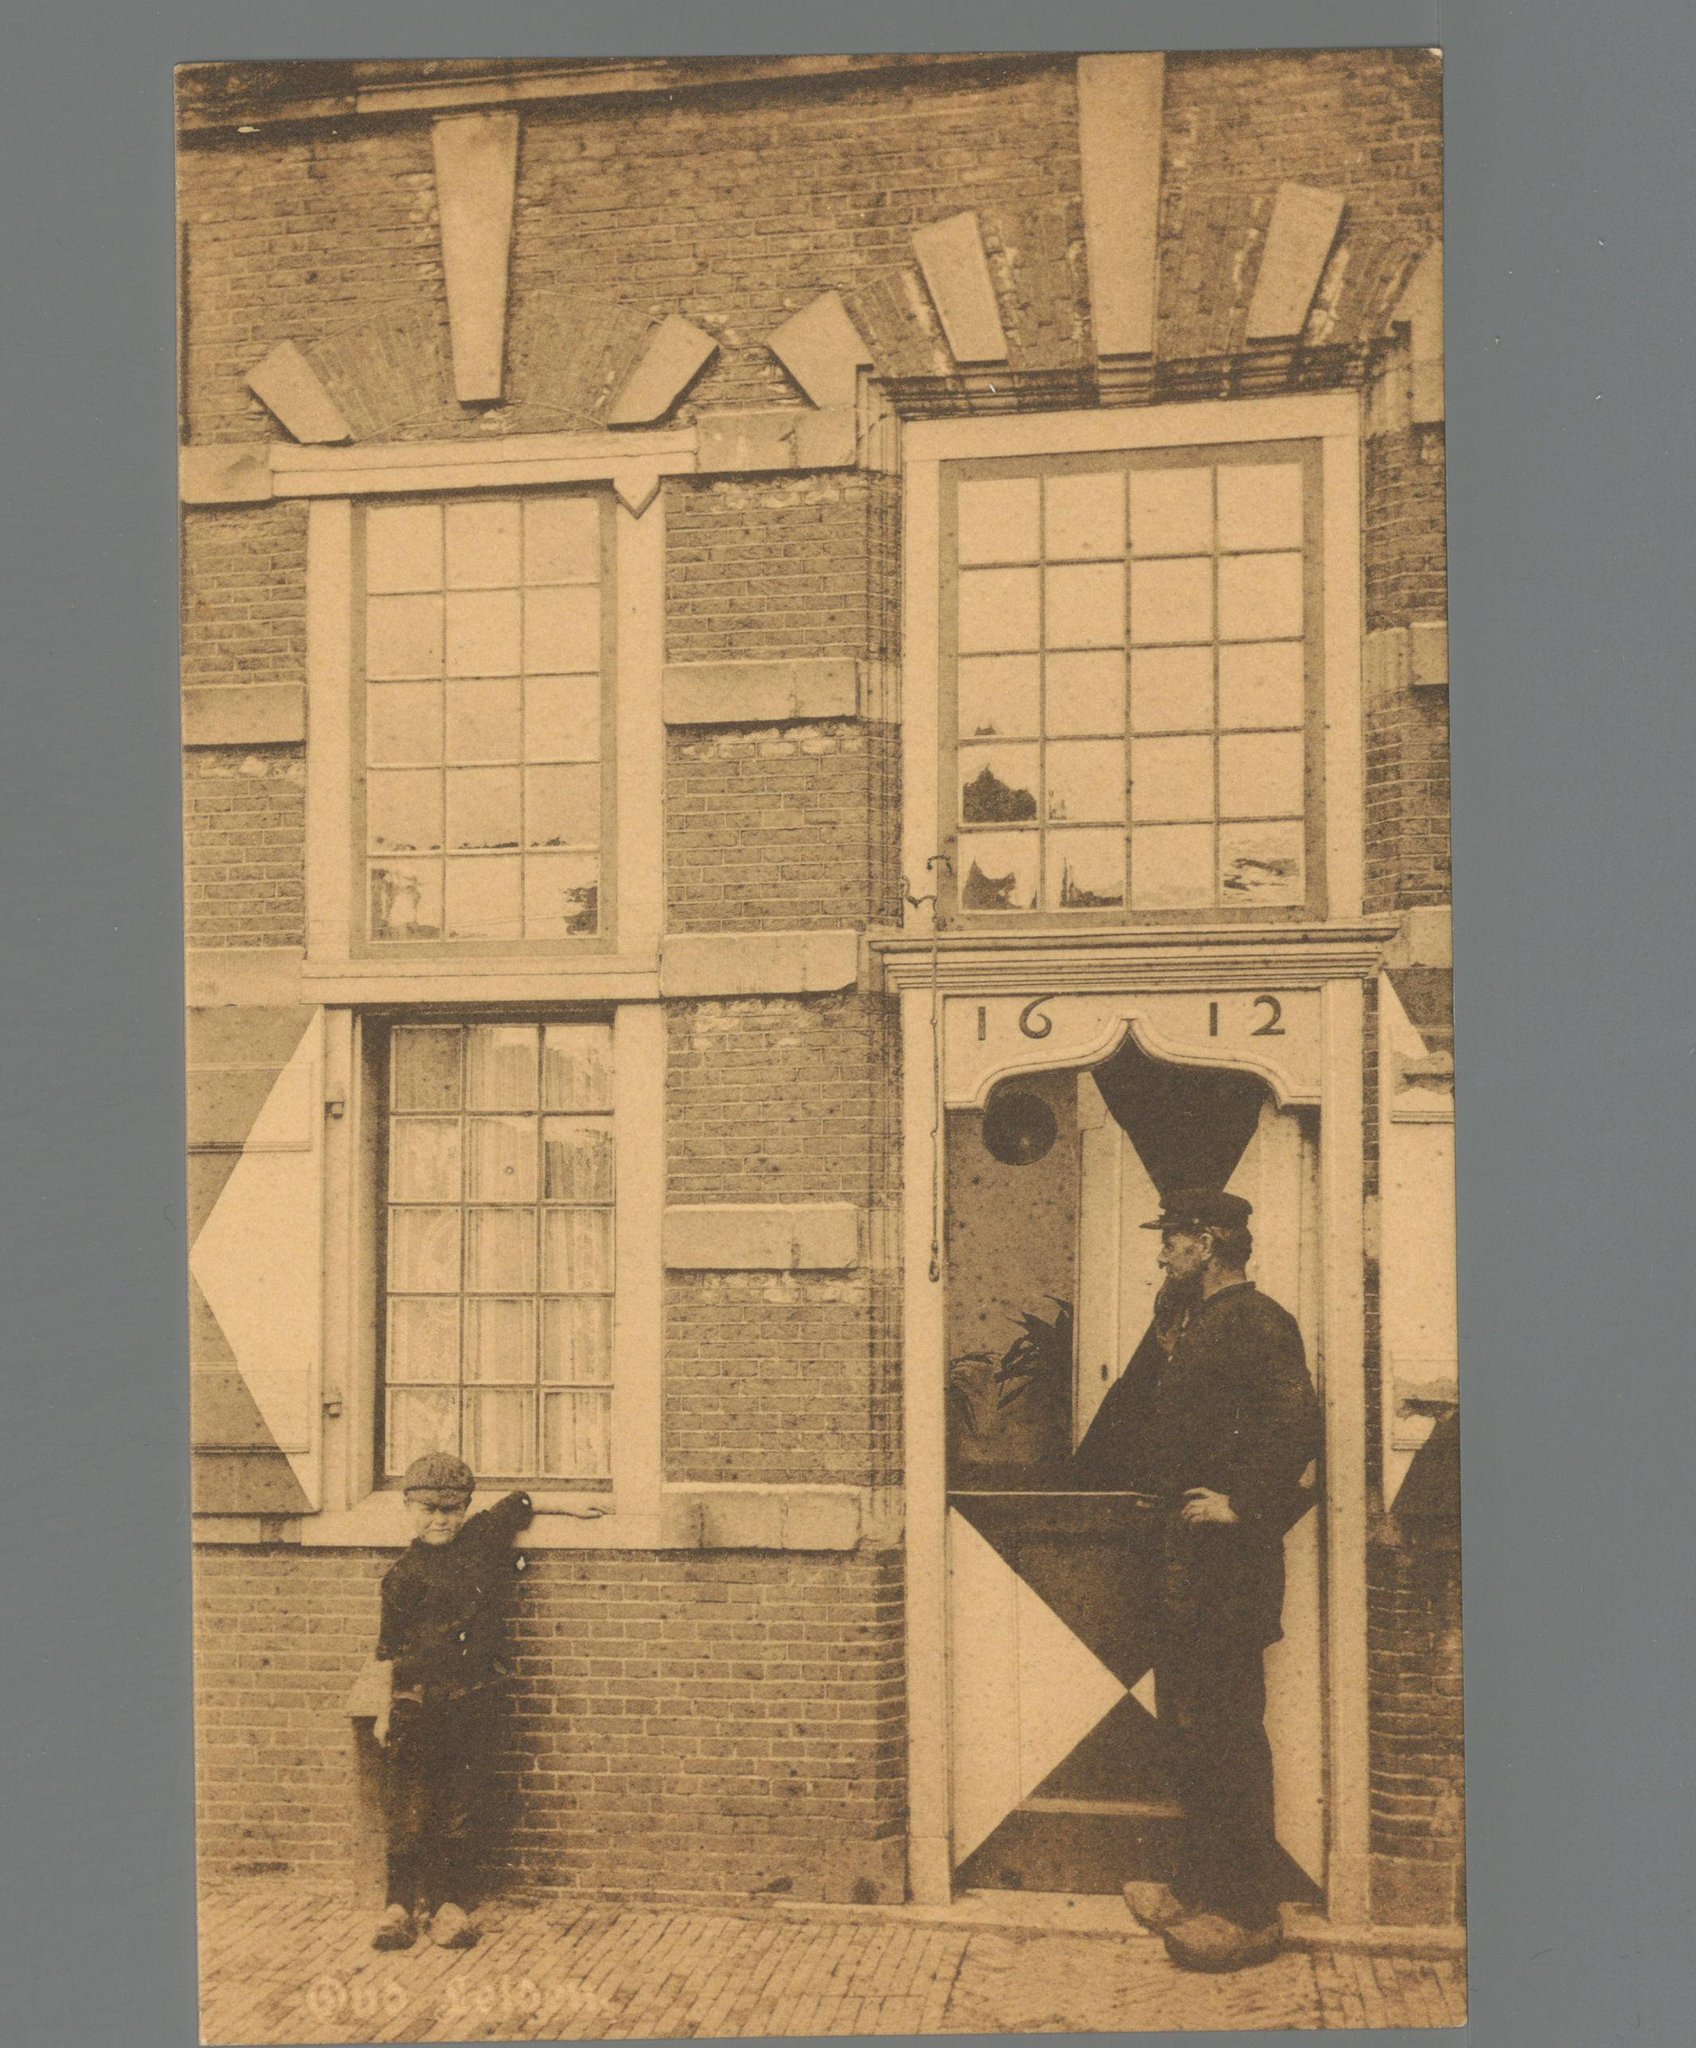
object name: photomechanical print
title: Stadstimmerwerf a. h. Galgewater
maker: Anonymous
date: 1905-1930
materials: cardboard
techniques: photograph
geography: leiden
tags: carpenter, workshop